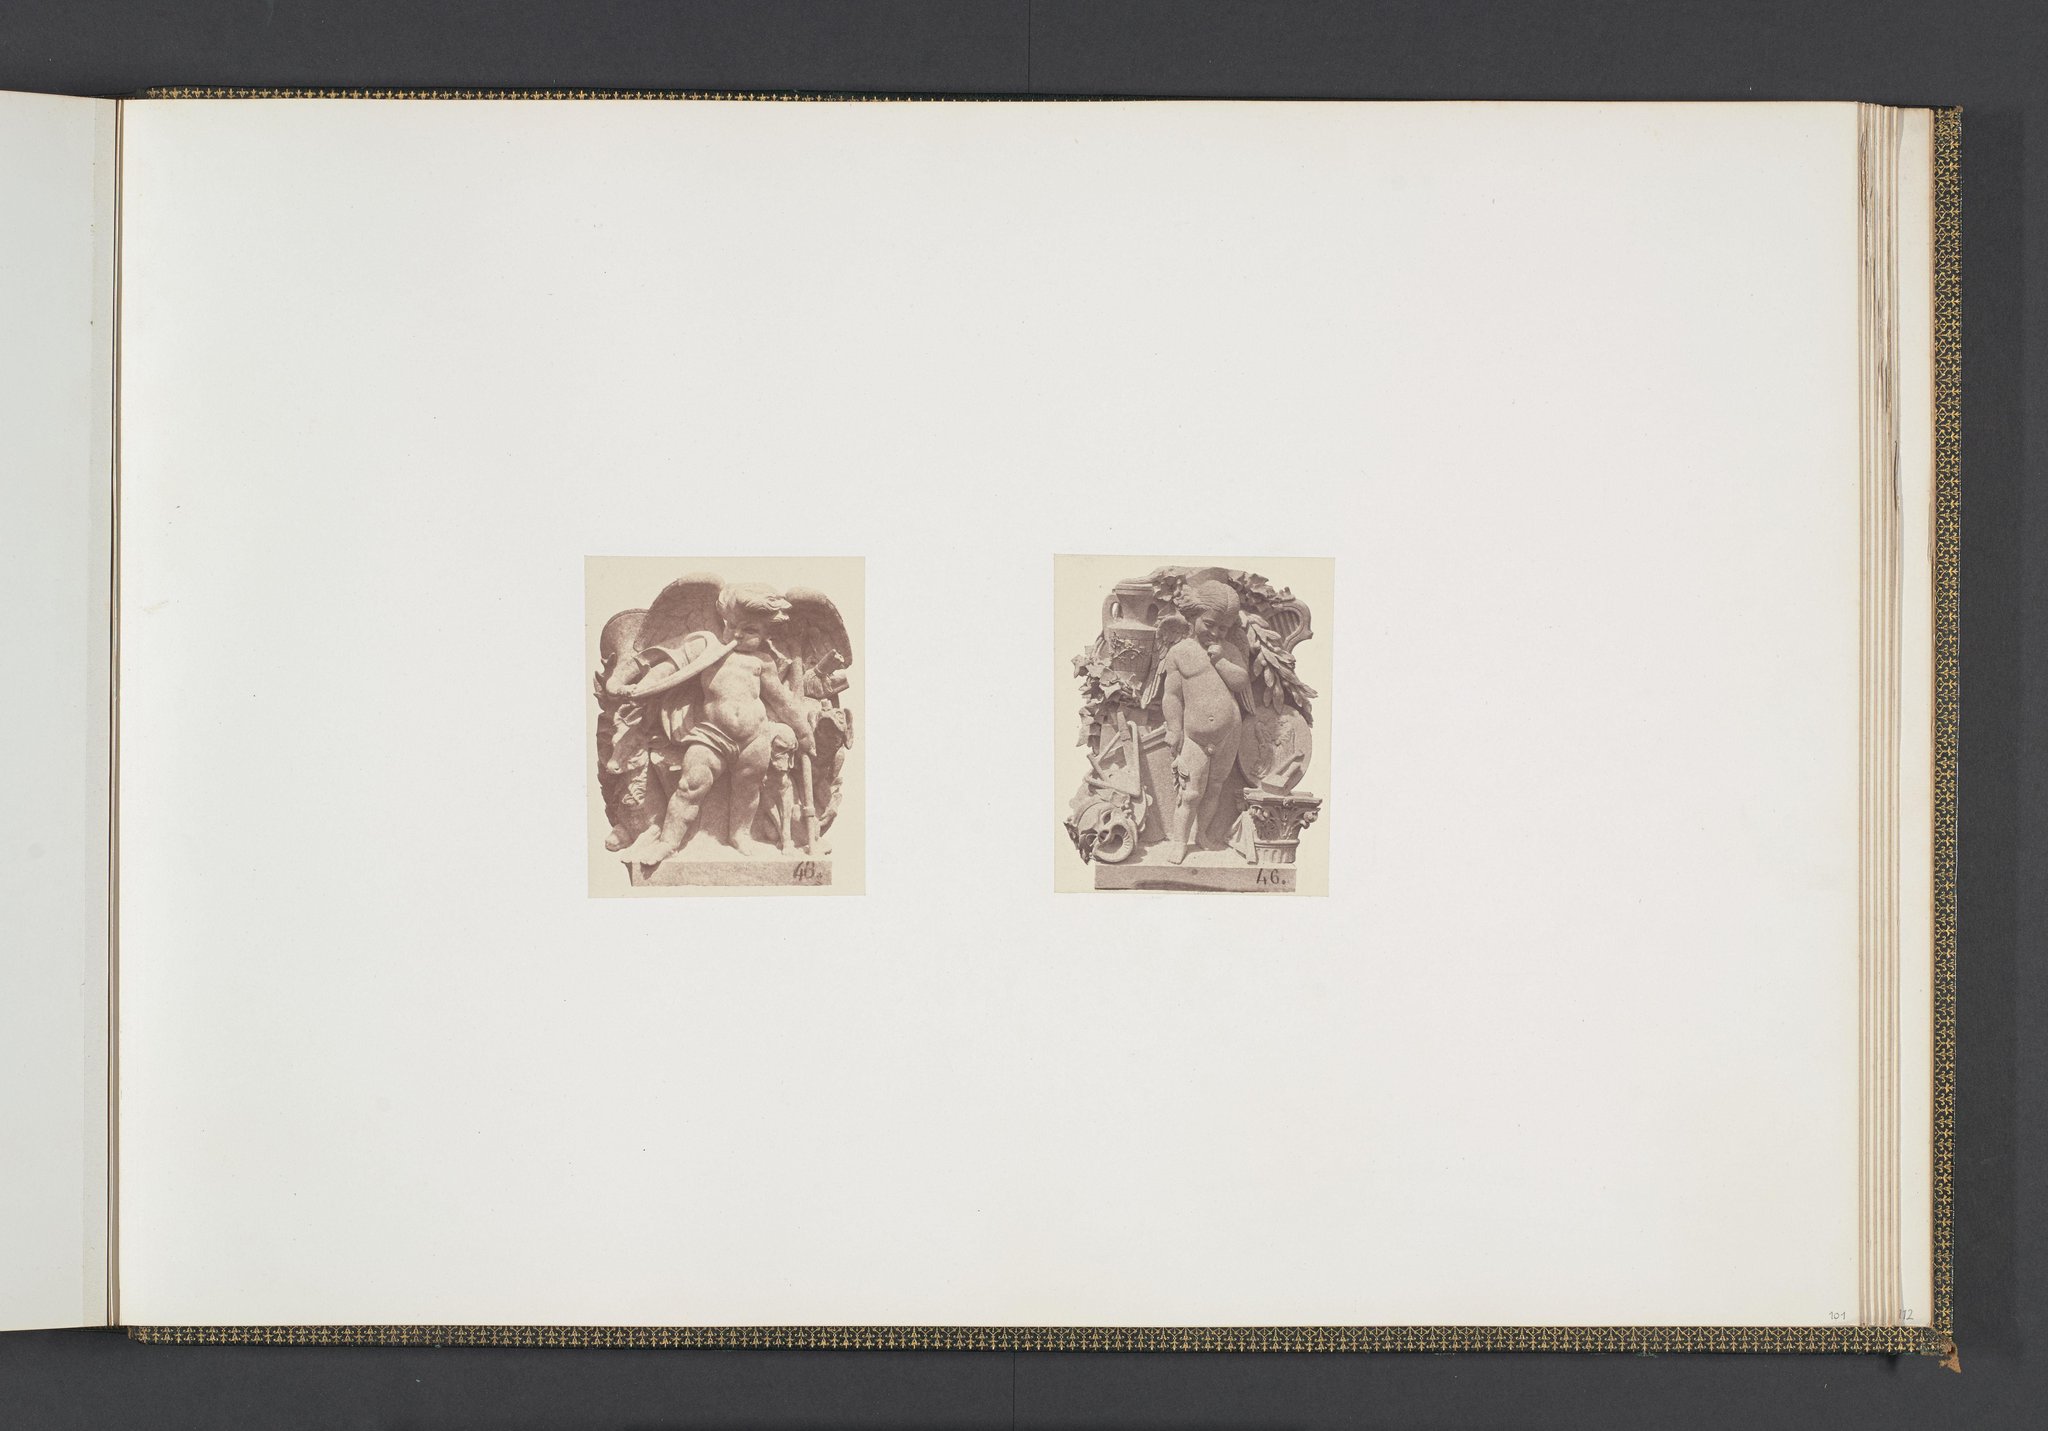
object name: album leaf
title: Gipsmodellen voor beeldhouwwerken op het Palais du Louvre: links "La Chasse" door Charles Auguste Lebourg en rechts "L'Art grec" door Charles Edouard Elmerich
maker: édouard denis baldus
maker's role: fotograaf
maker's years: 1813-1889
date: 1855-1857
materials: paper, photographic support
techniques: salted paper print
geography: paris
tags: piece of sculpture, reproduction of a piece of sculpture, permanent exhibition, museum, paris, tuileries palace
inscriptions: number: ‘48 en 46’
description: Onderdeel van Réunion des Tuileries au Louvre 1852-1857, album 2.